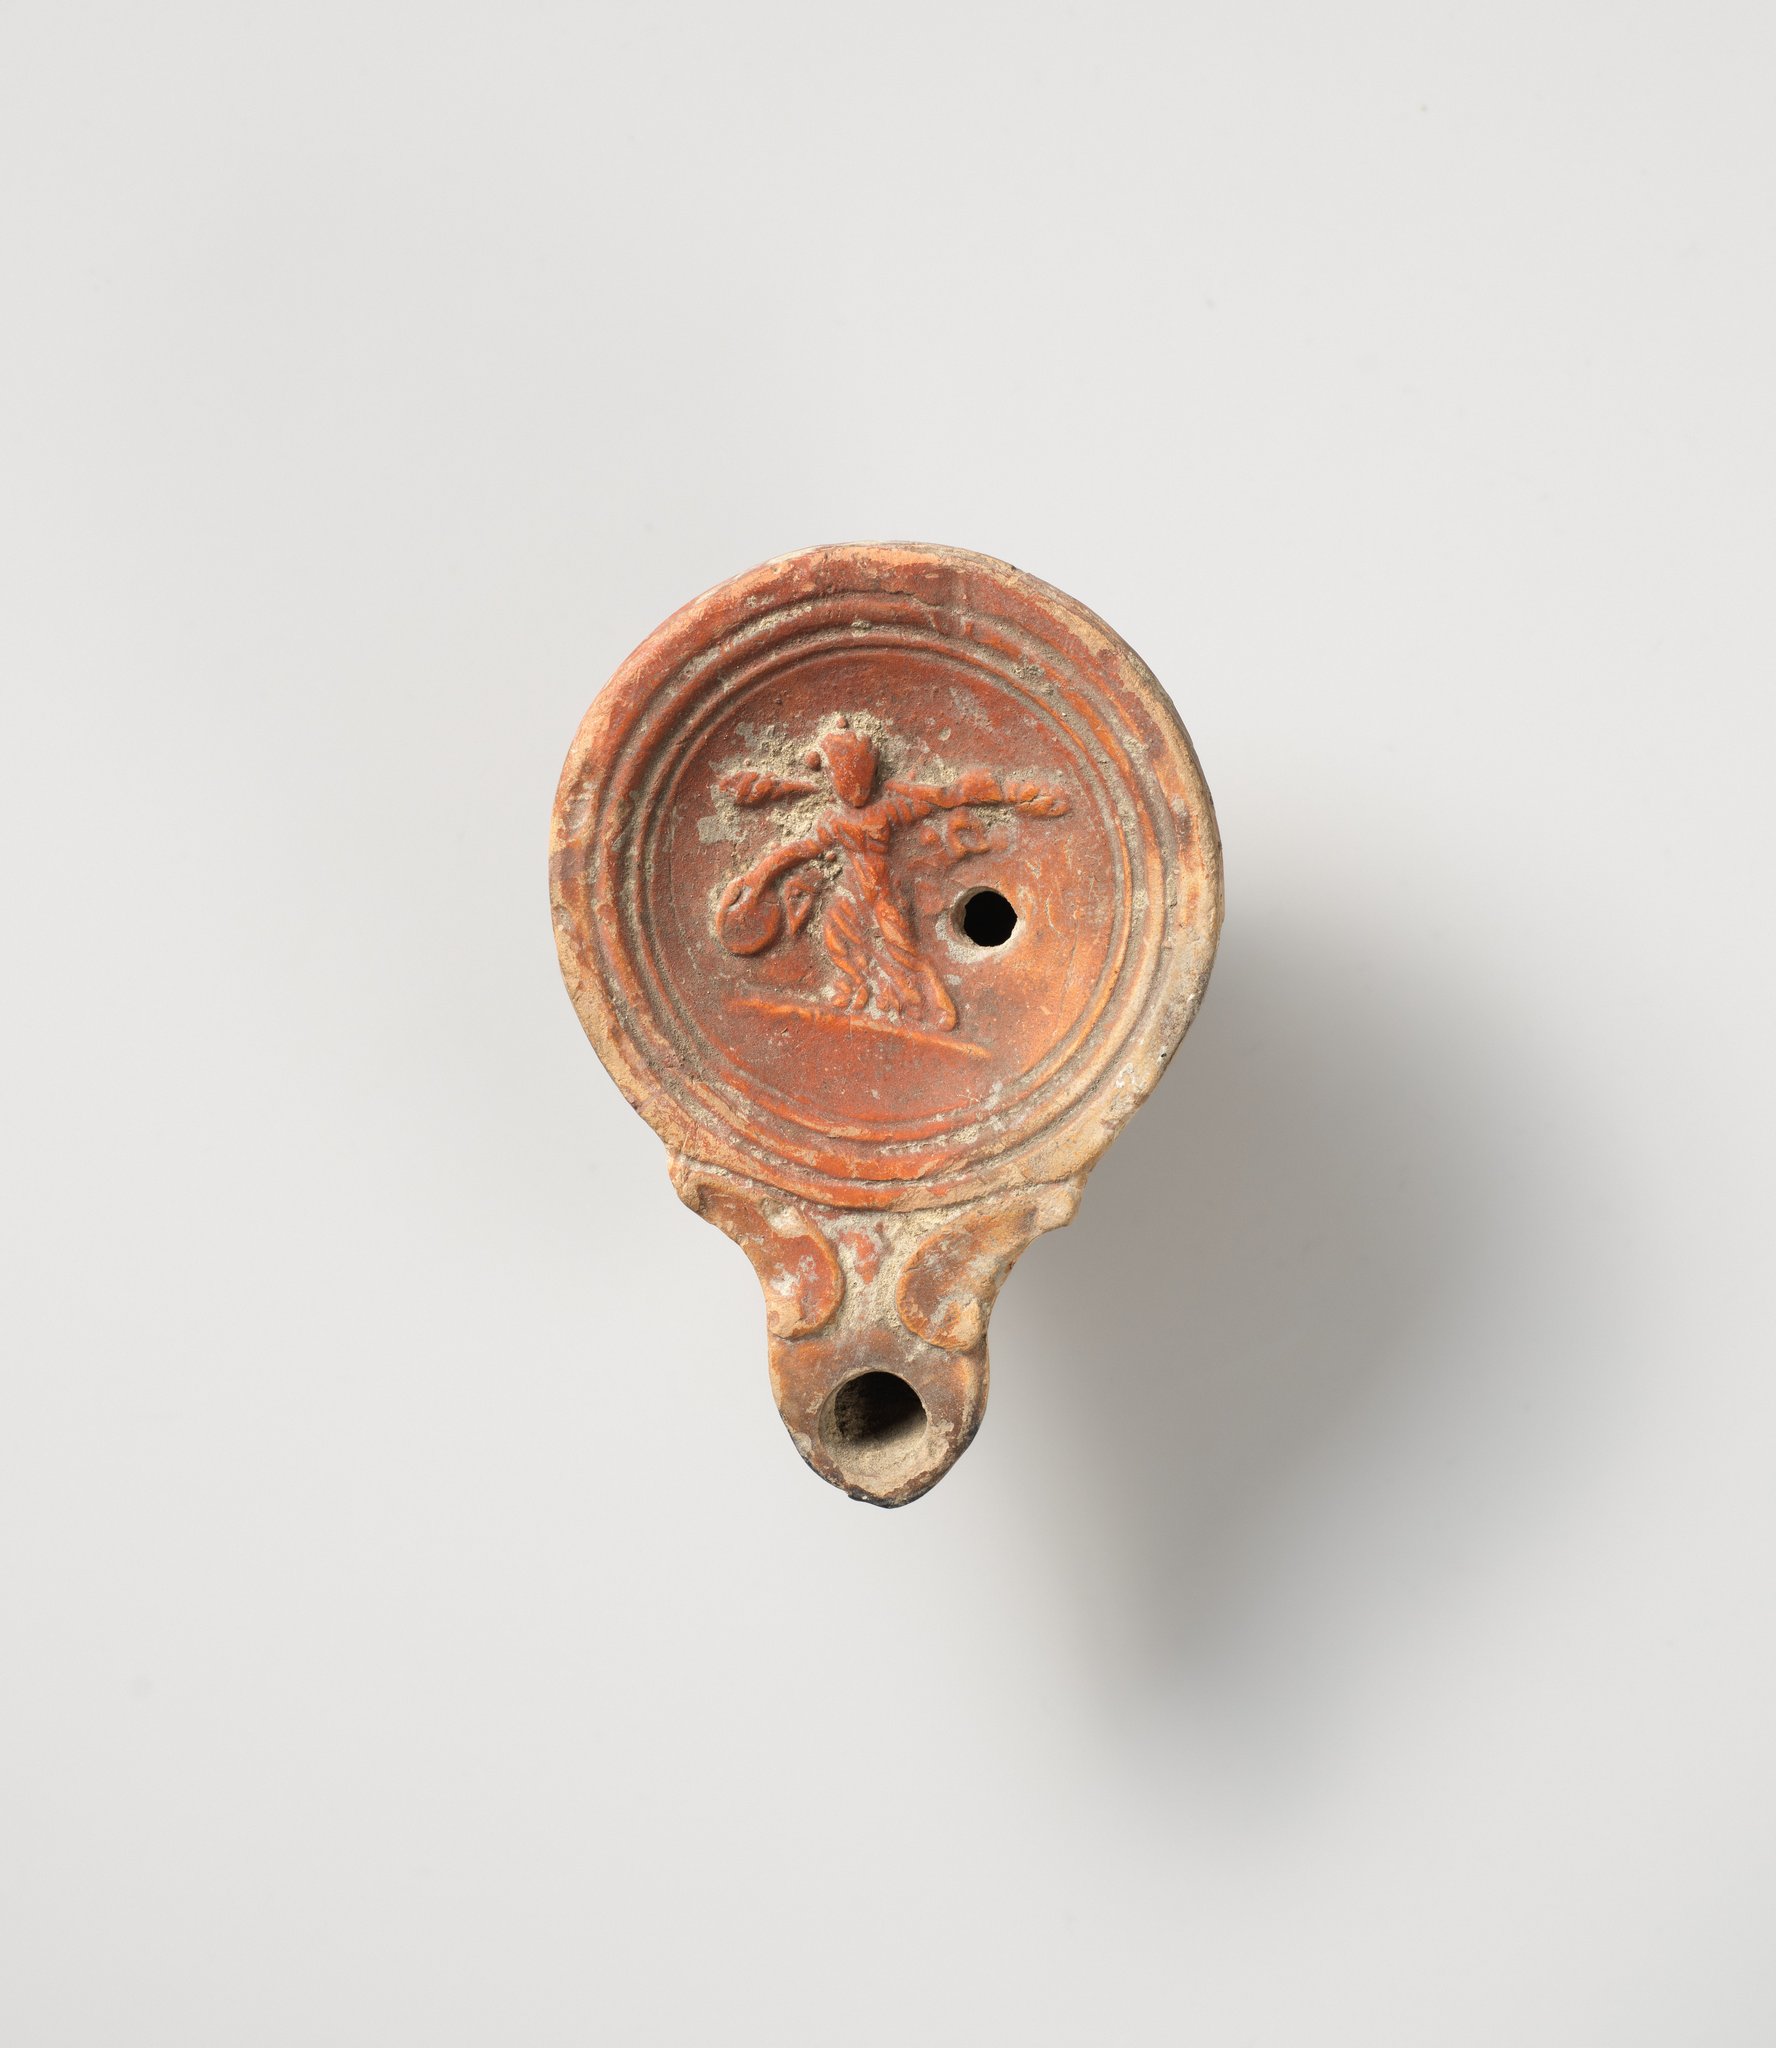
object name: lamp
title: Terracotta oil lamp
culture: roman, cypriot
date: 40-100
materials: terracotta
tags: maenads